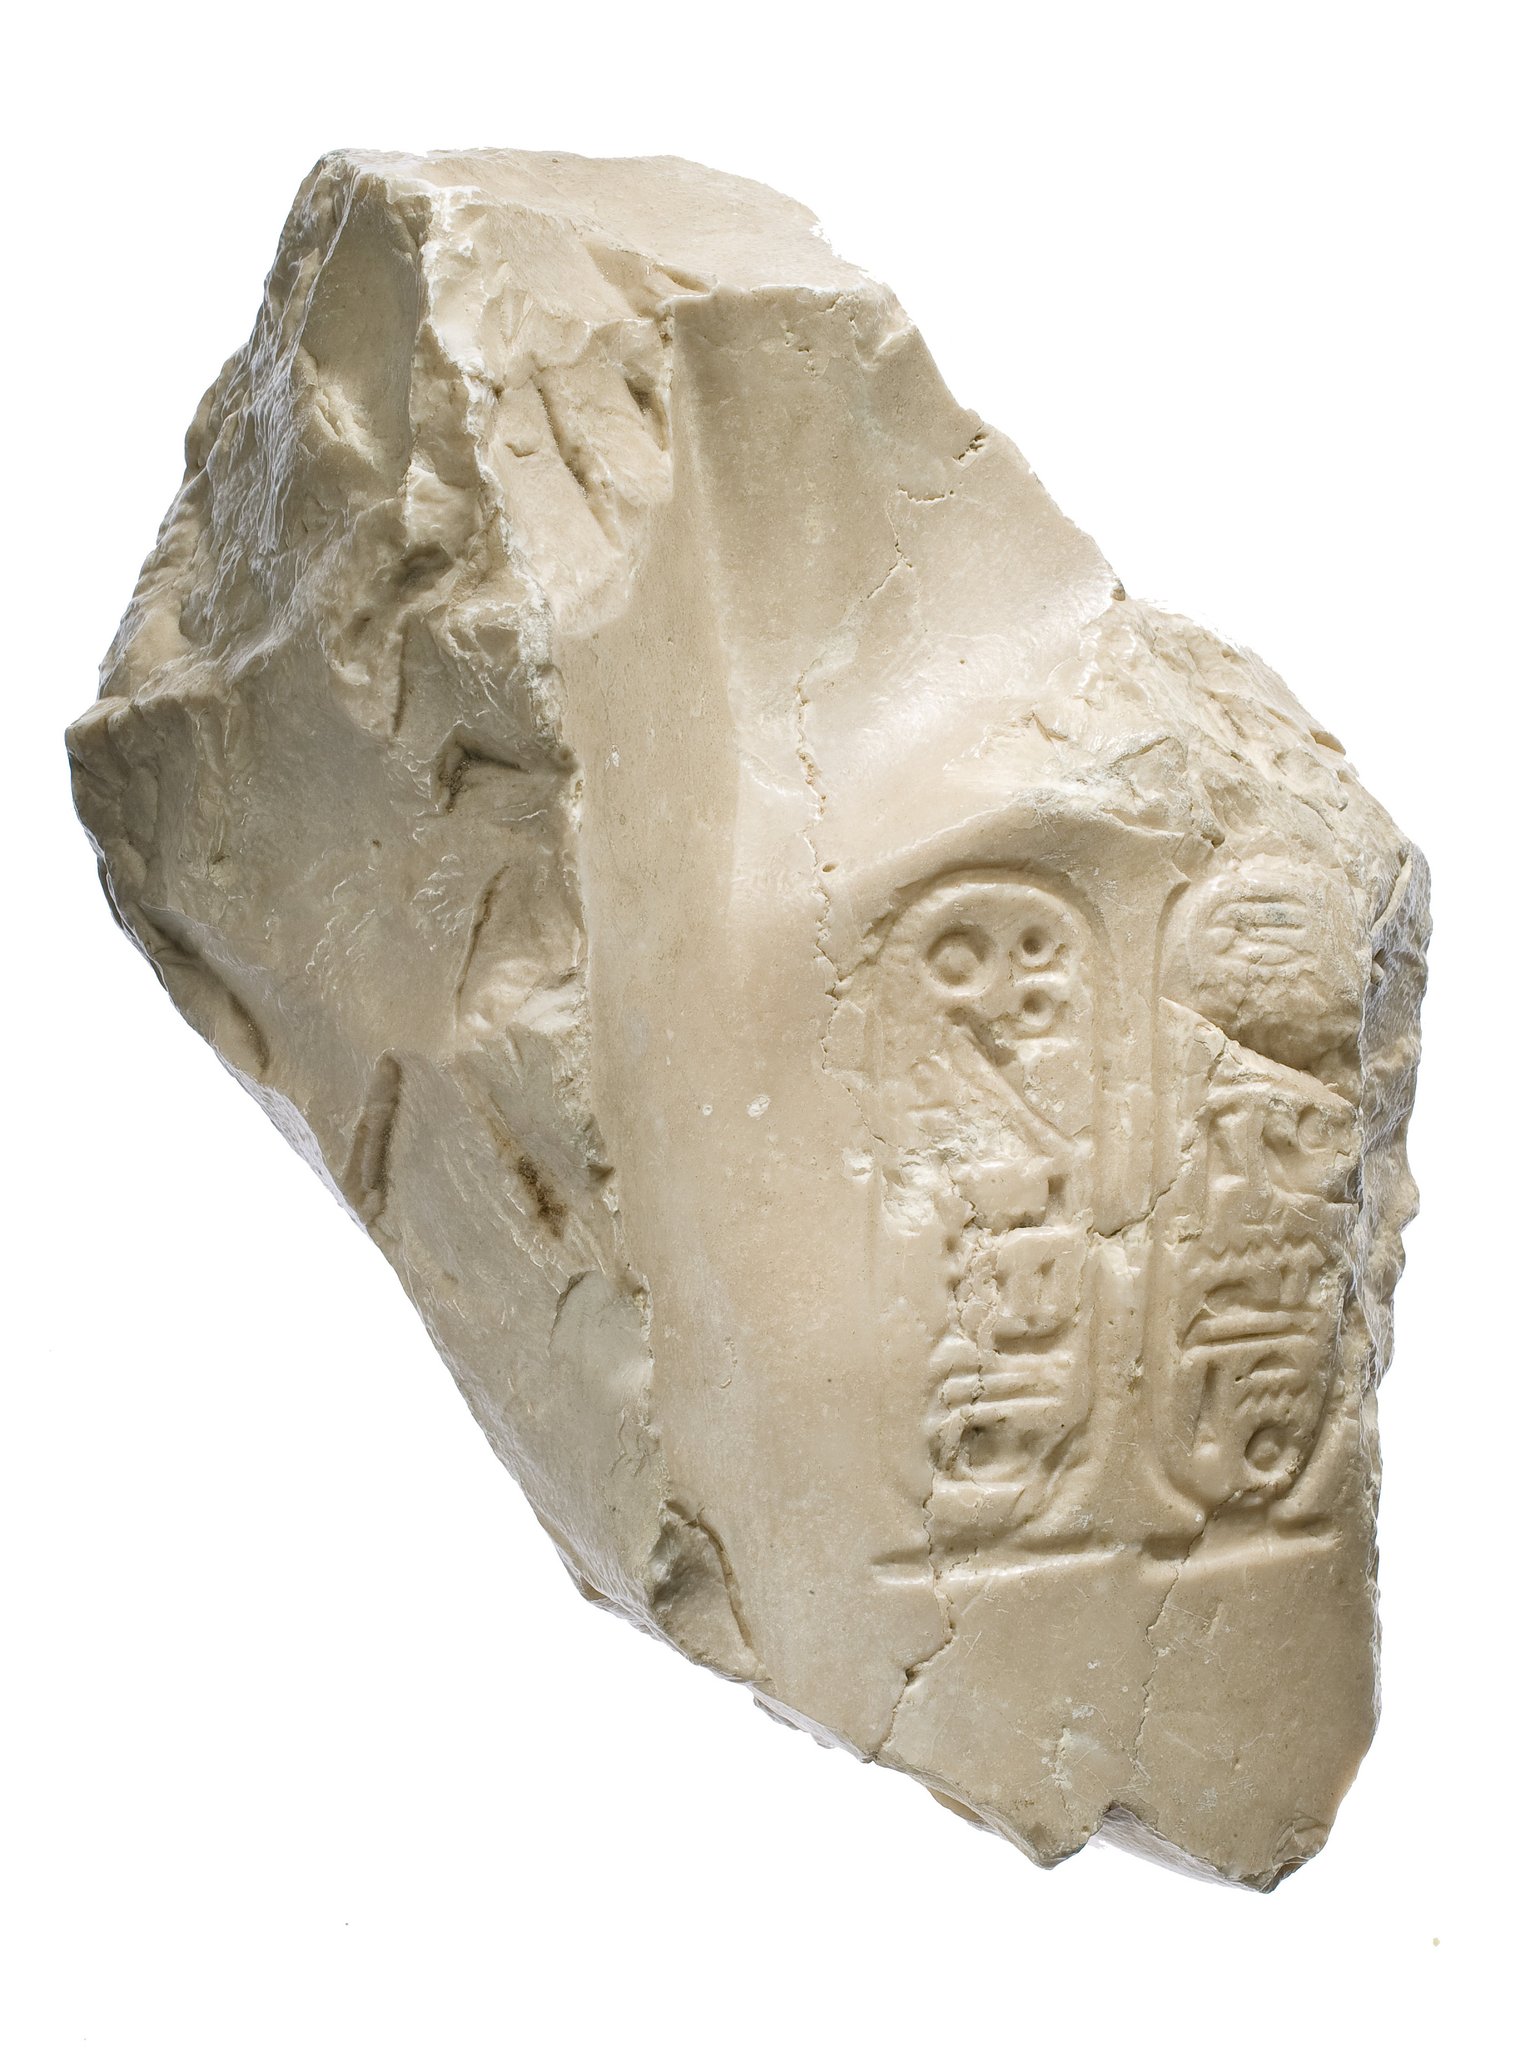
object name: akhenaten chest, aten cartouch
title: Akhenaten chest with Aten cartouches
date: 1353-1336 BCE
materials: limestone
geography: egypt